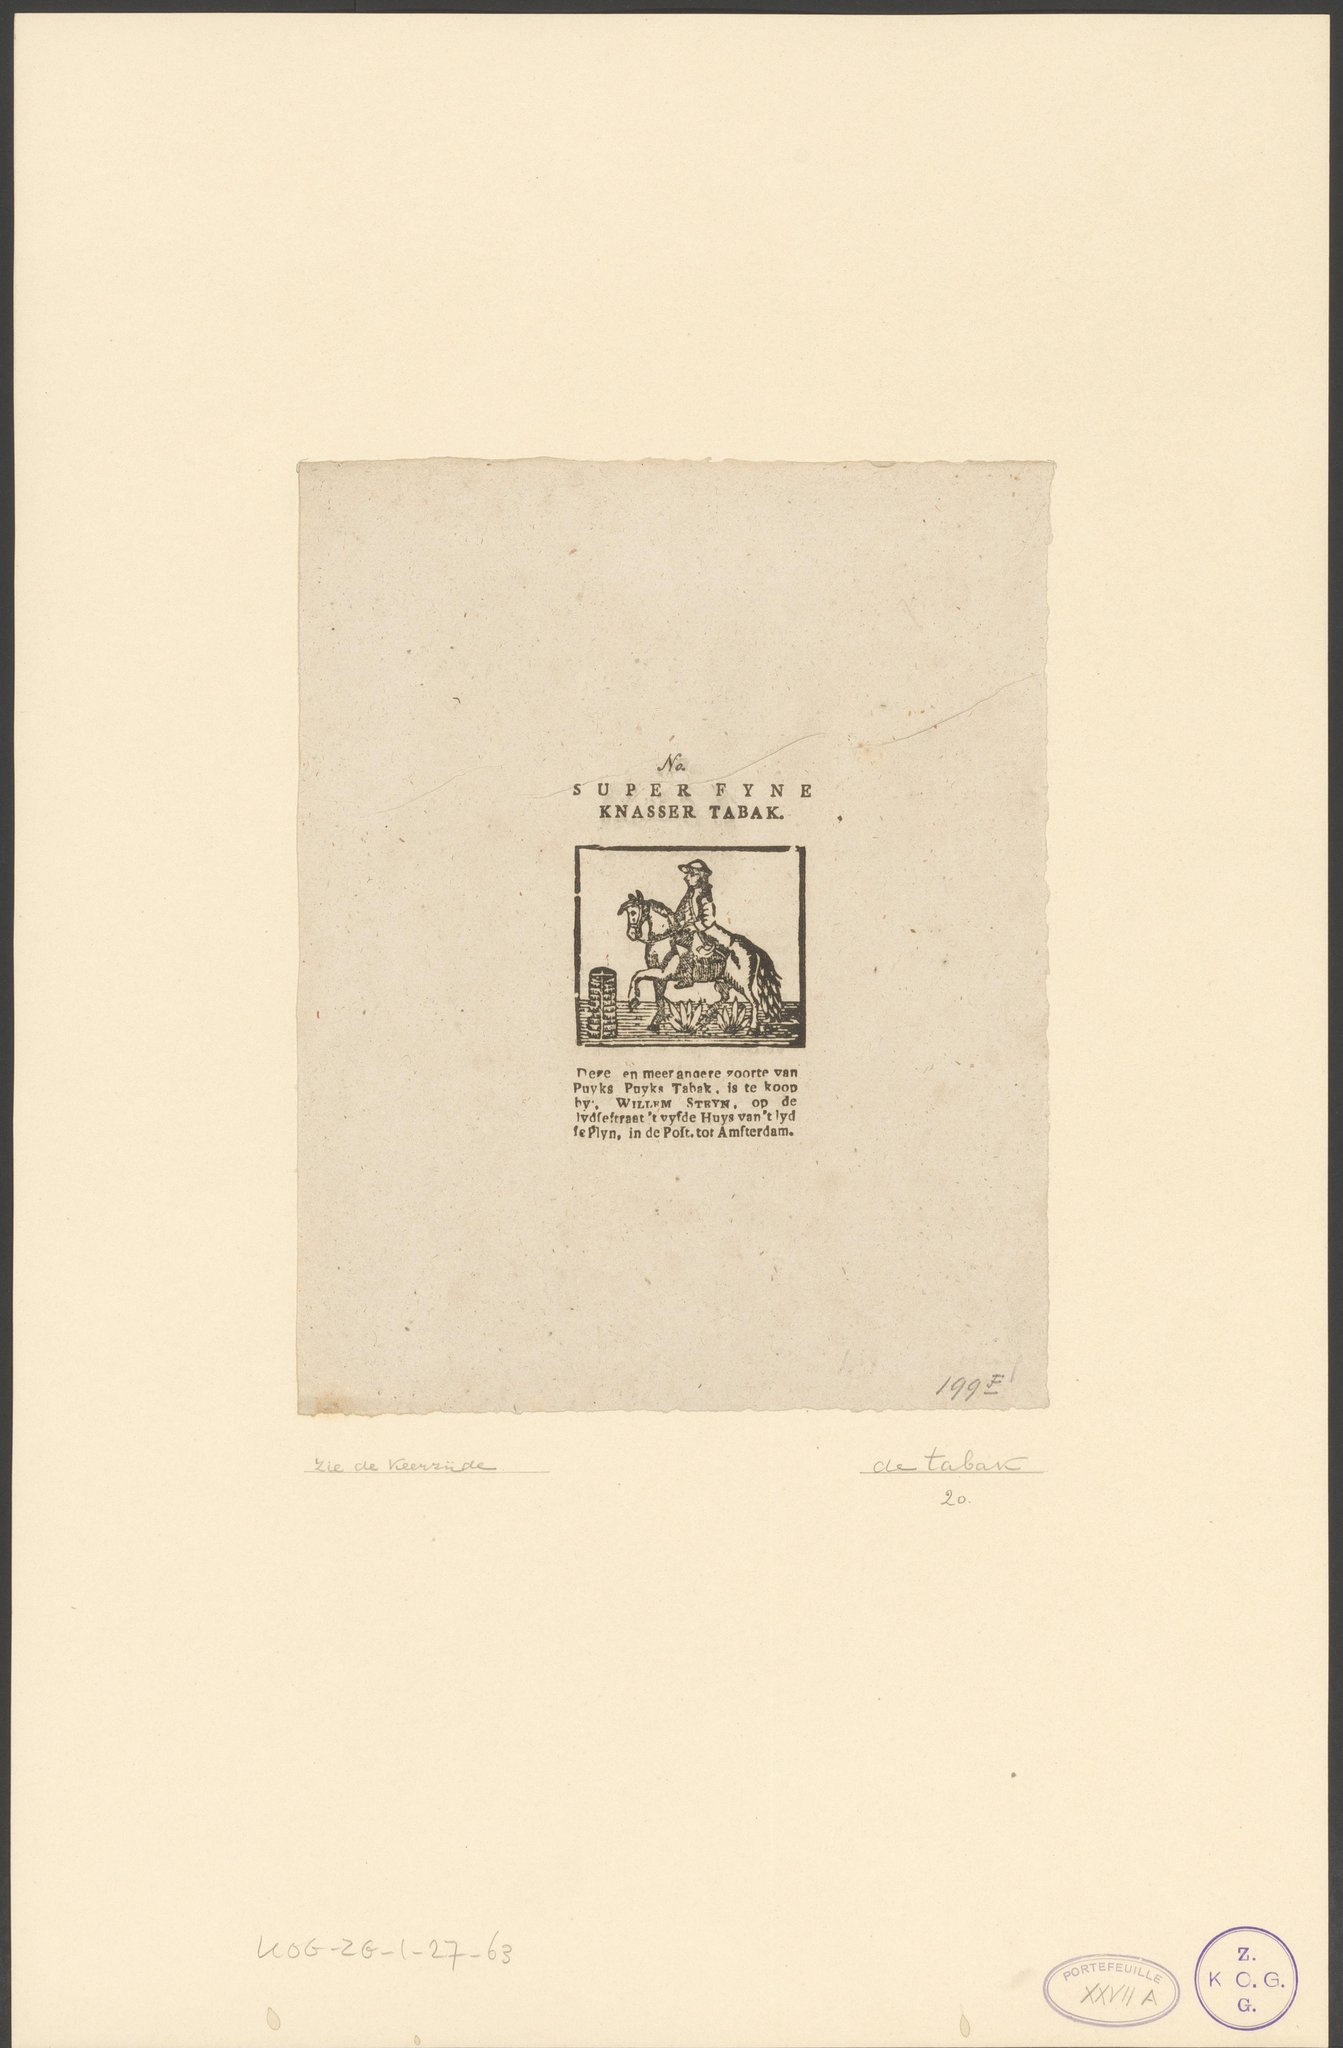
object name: label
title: Etiket voor tabaksverpakking van Willem Steyn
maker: Anonymous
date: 1750-1800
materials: paper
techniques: letterpress printing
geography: netherlands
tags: (non-fruit) products of plants or trees: tobacco, postman, tobacco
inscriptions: collector's mark: Lugt 1641, collector's mark